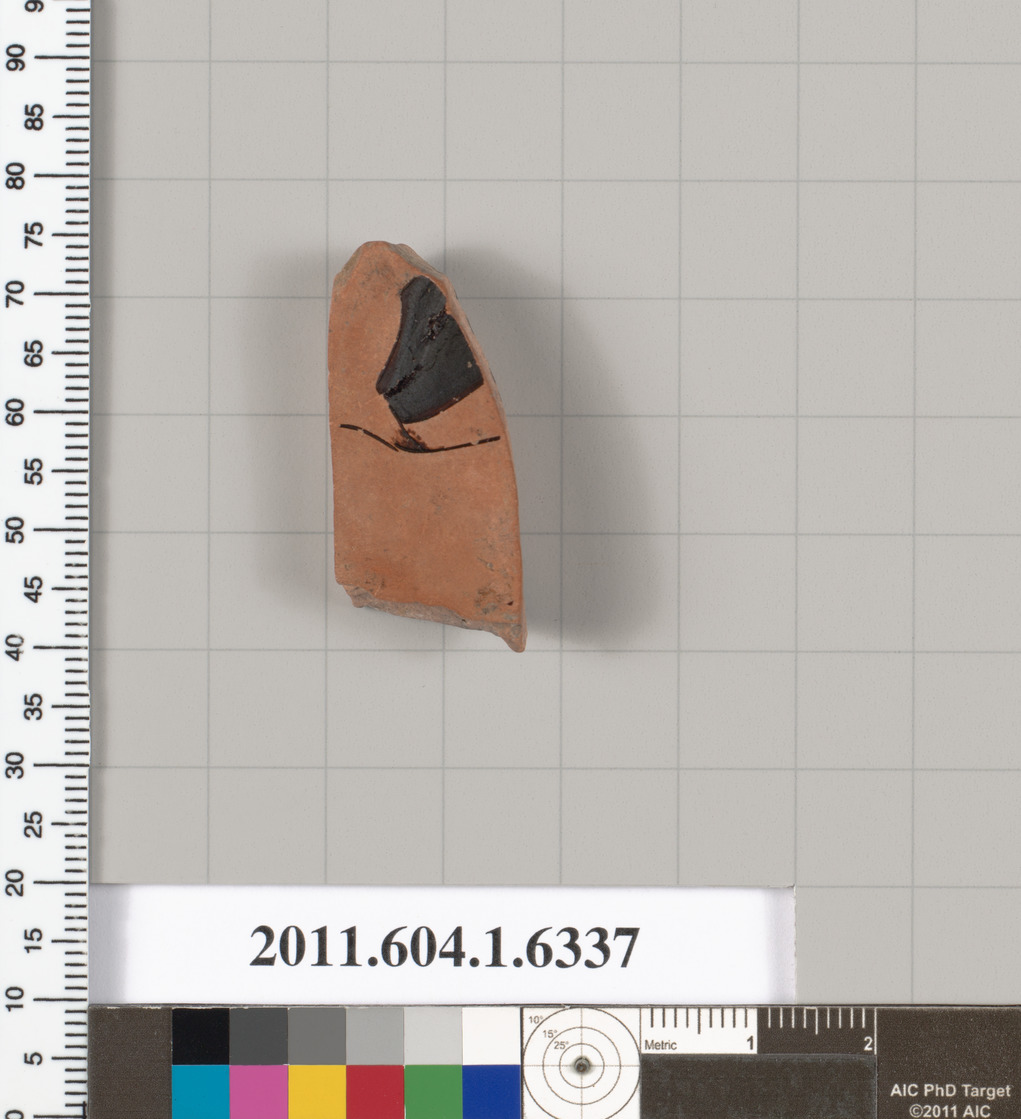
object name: kylix fragment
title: Terracotta fragment of a kylix (drinking cup)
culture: greek, attic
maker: onesimos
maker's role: artist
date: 500-480 BCE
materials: terracotta